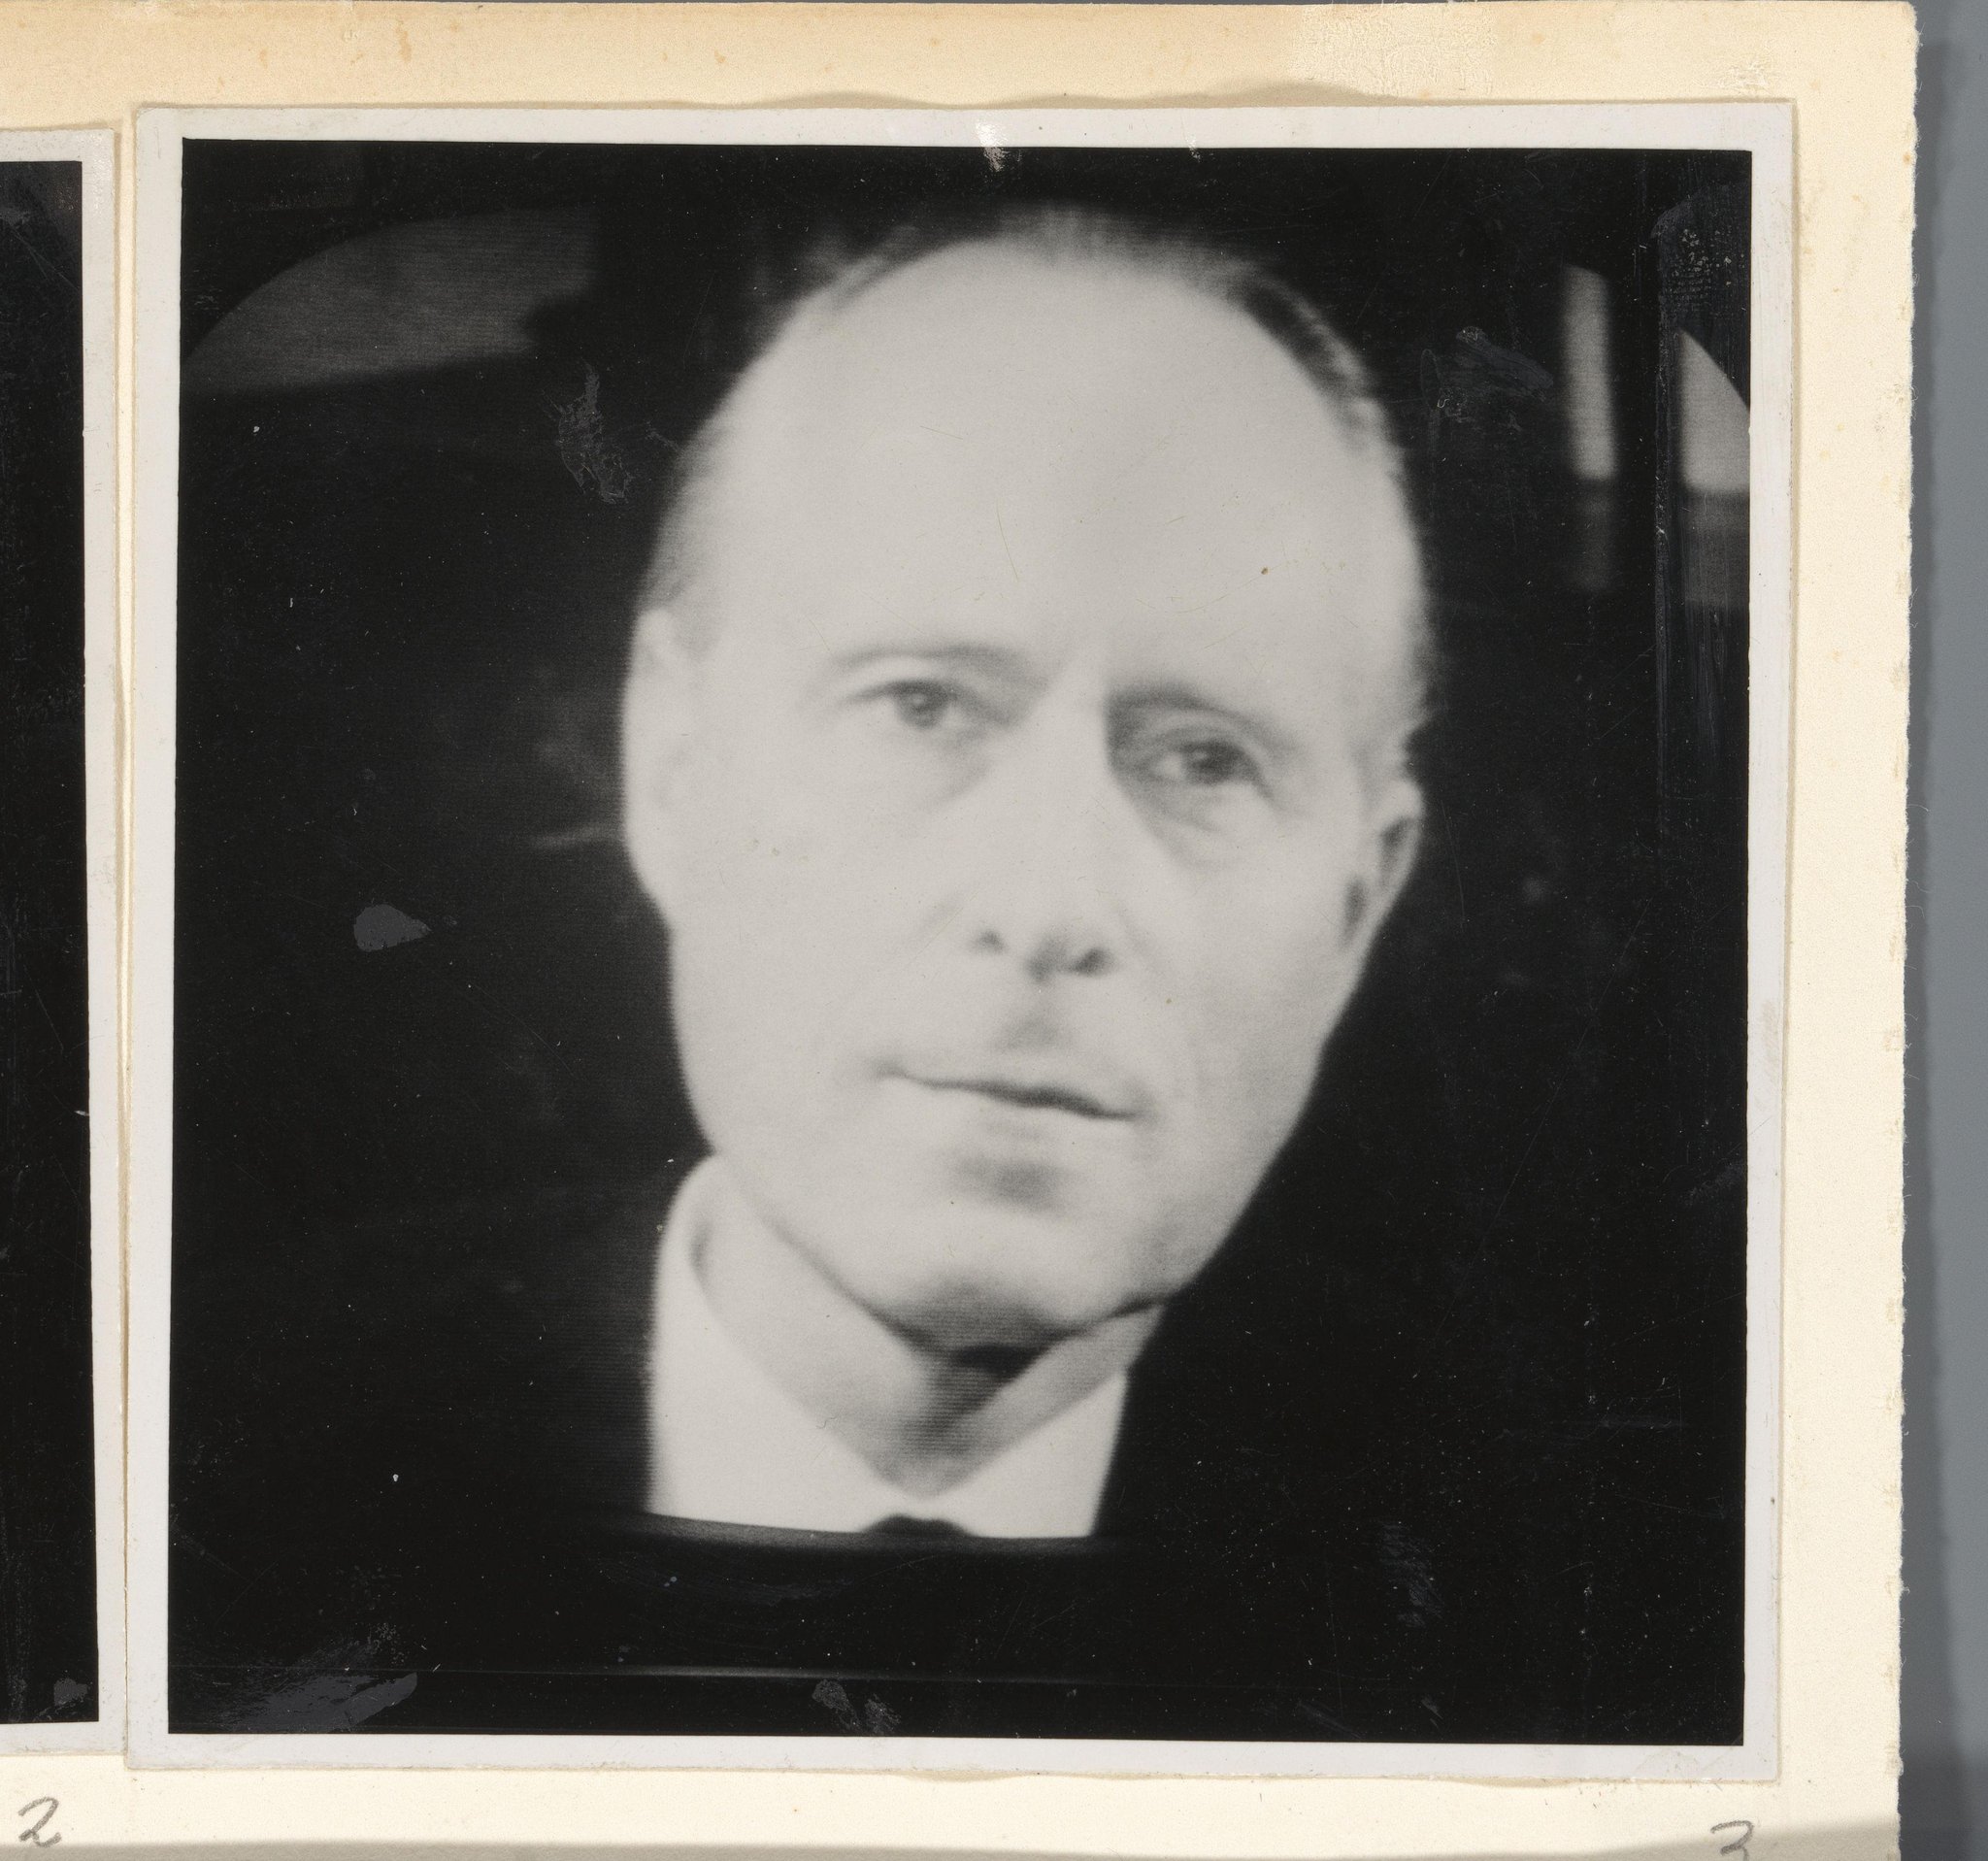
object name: photograph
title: Foto van televisiebeeldscherm, waarschijnlijk tijdens de uitzending van de film 'Carel Willink' door Helène van Zijl, Lies Westenburg en Hans Redeker (1963)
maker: Anonymous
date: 1963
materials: cardboard, paper, photographic support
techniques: gelatin silver print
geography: netherlands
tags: television, television broadcasting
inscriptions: stamp: ‘FOTO E. VAN MOERKERKEN / COPYRIGHT / E. VAN MOERKERKEN / AMSTERDAM / No.’